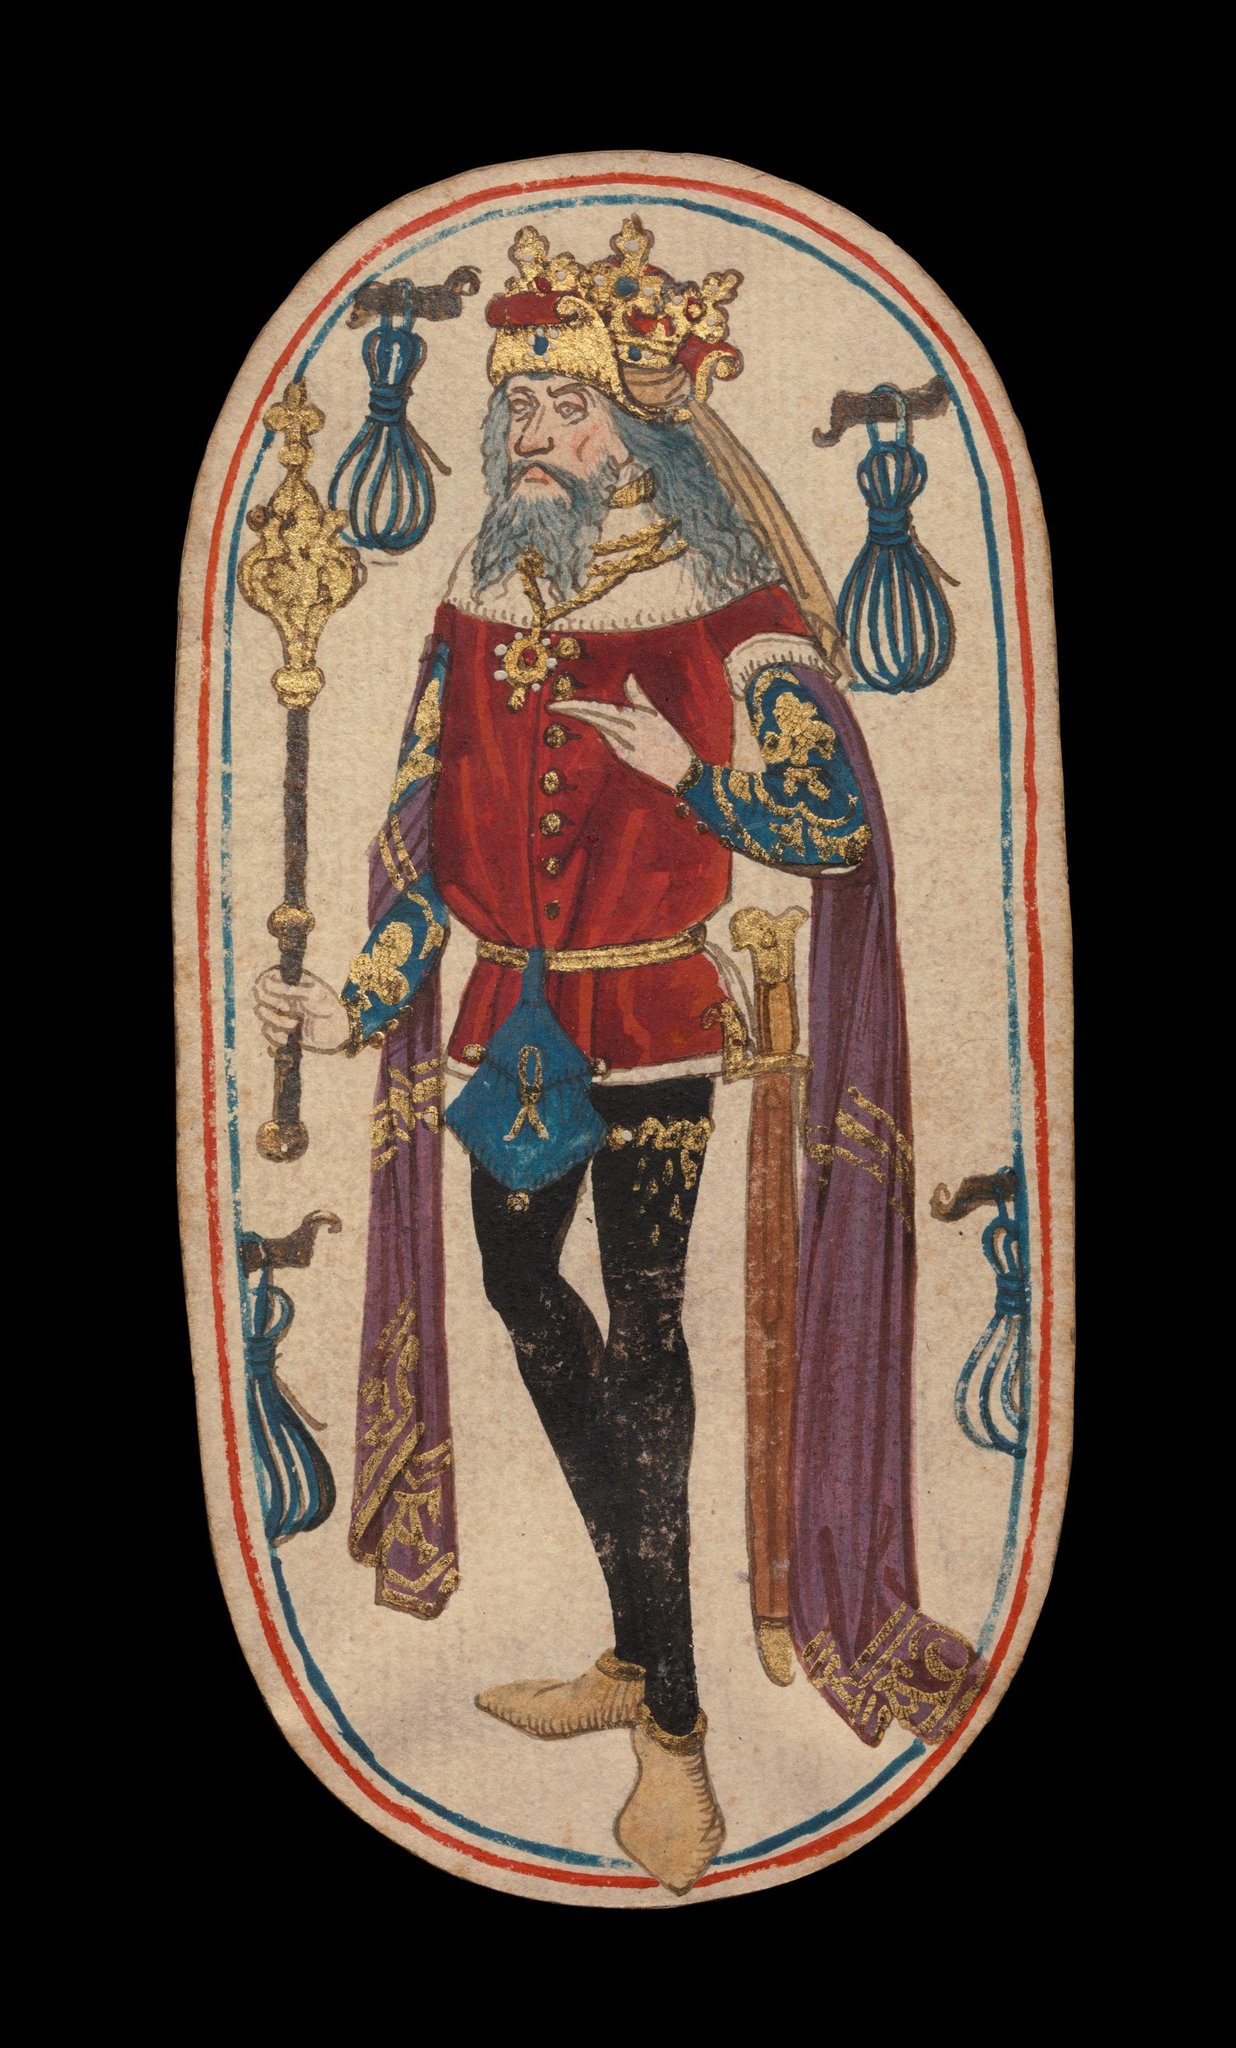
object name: playing card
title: King of Tethers, from The Cloisters Playing Cards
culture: south netherlandish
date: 1475-1480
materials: glaze, gold, ink, paint, paper, silver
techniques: pen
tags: kings,playing cards,games